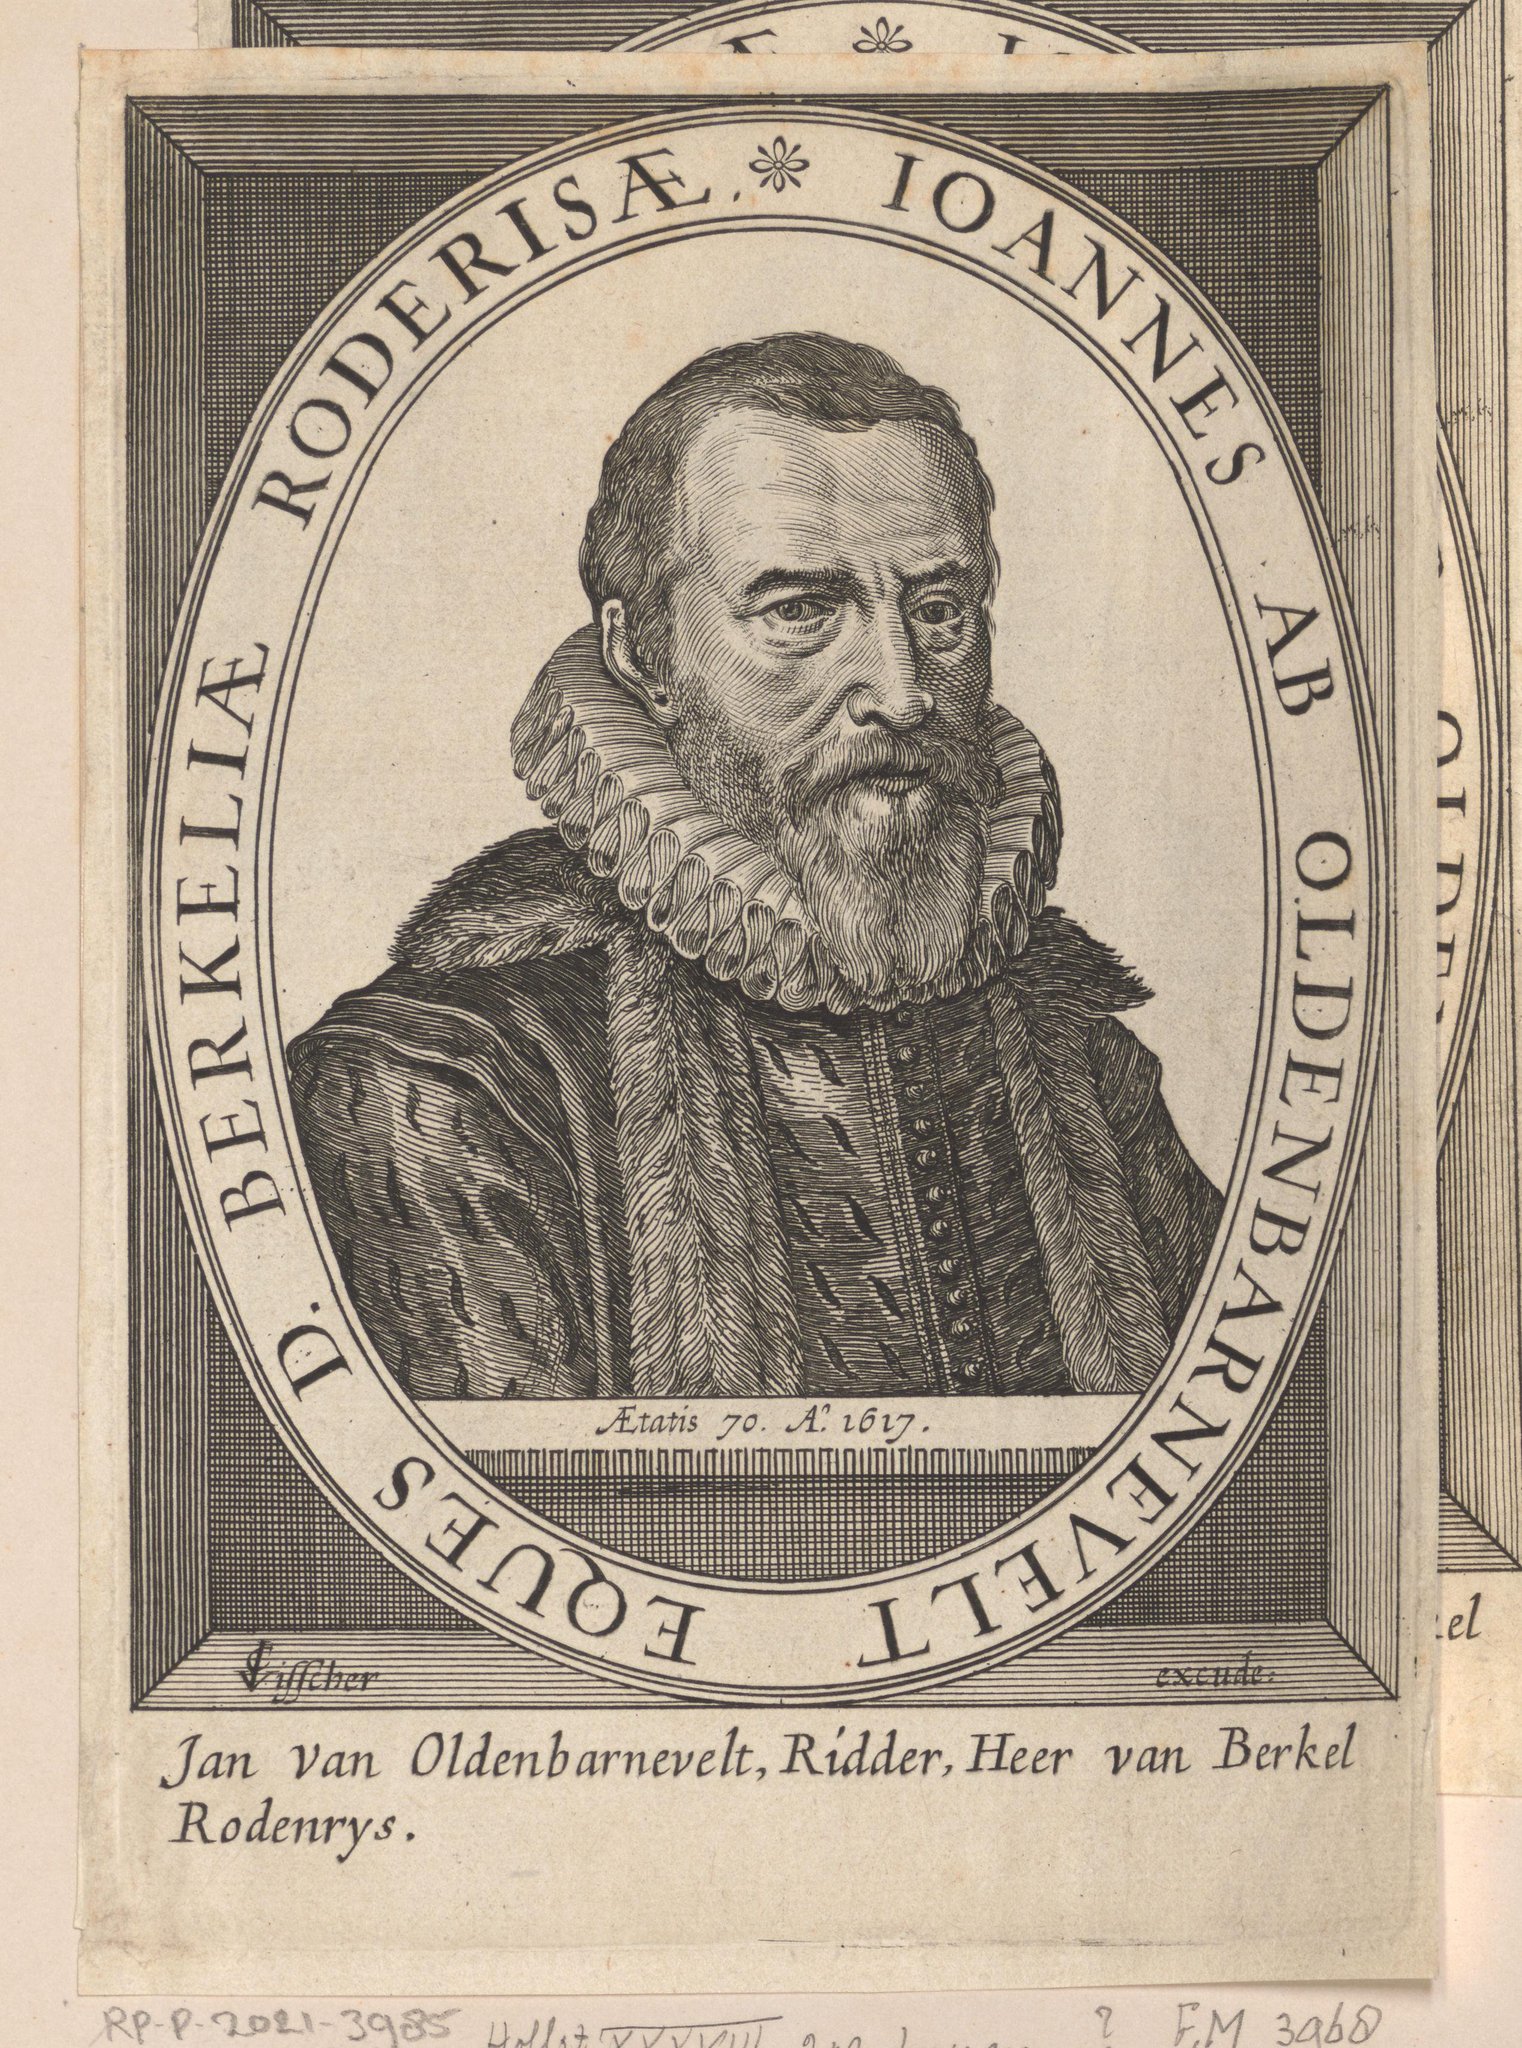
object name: print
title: Portret van Johan van Oldenbarnevelt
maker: claes jansz. visscher (ii)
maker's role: draughtsman, print maker, publisher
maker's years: 1586-1652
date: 1617-1619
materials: paper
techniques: engraving, etching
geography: amsterdam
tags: the hague, johan van oldenbarnevelt, historical persons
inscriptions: collector's mark: Lugt 240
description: Prent mogelijk geknipt uit een groter blad, gedrukt uit meerdere platen (zie RP-P-OB-77.320).